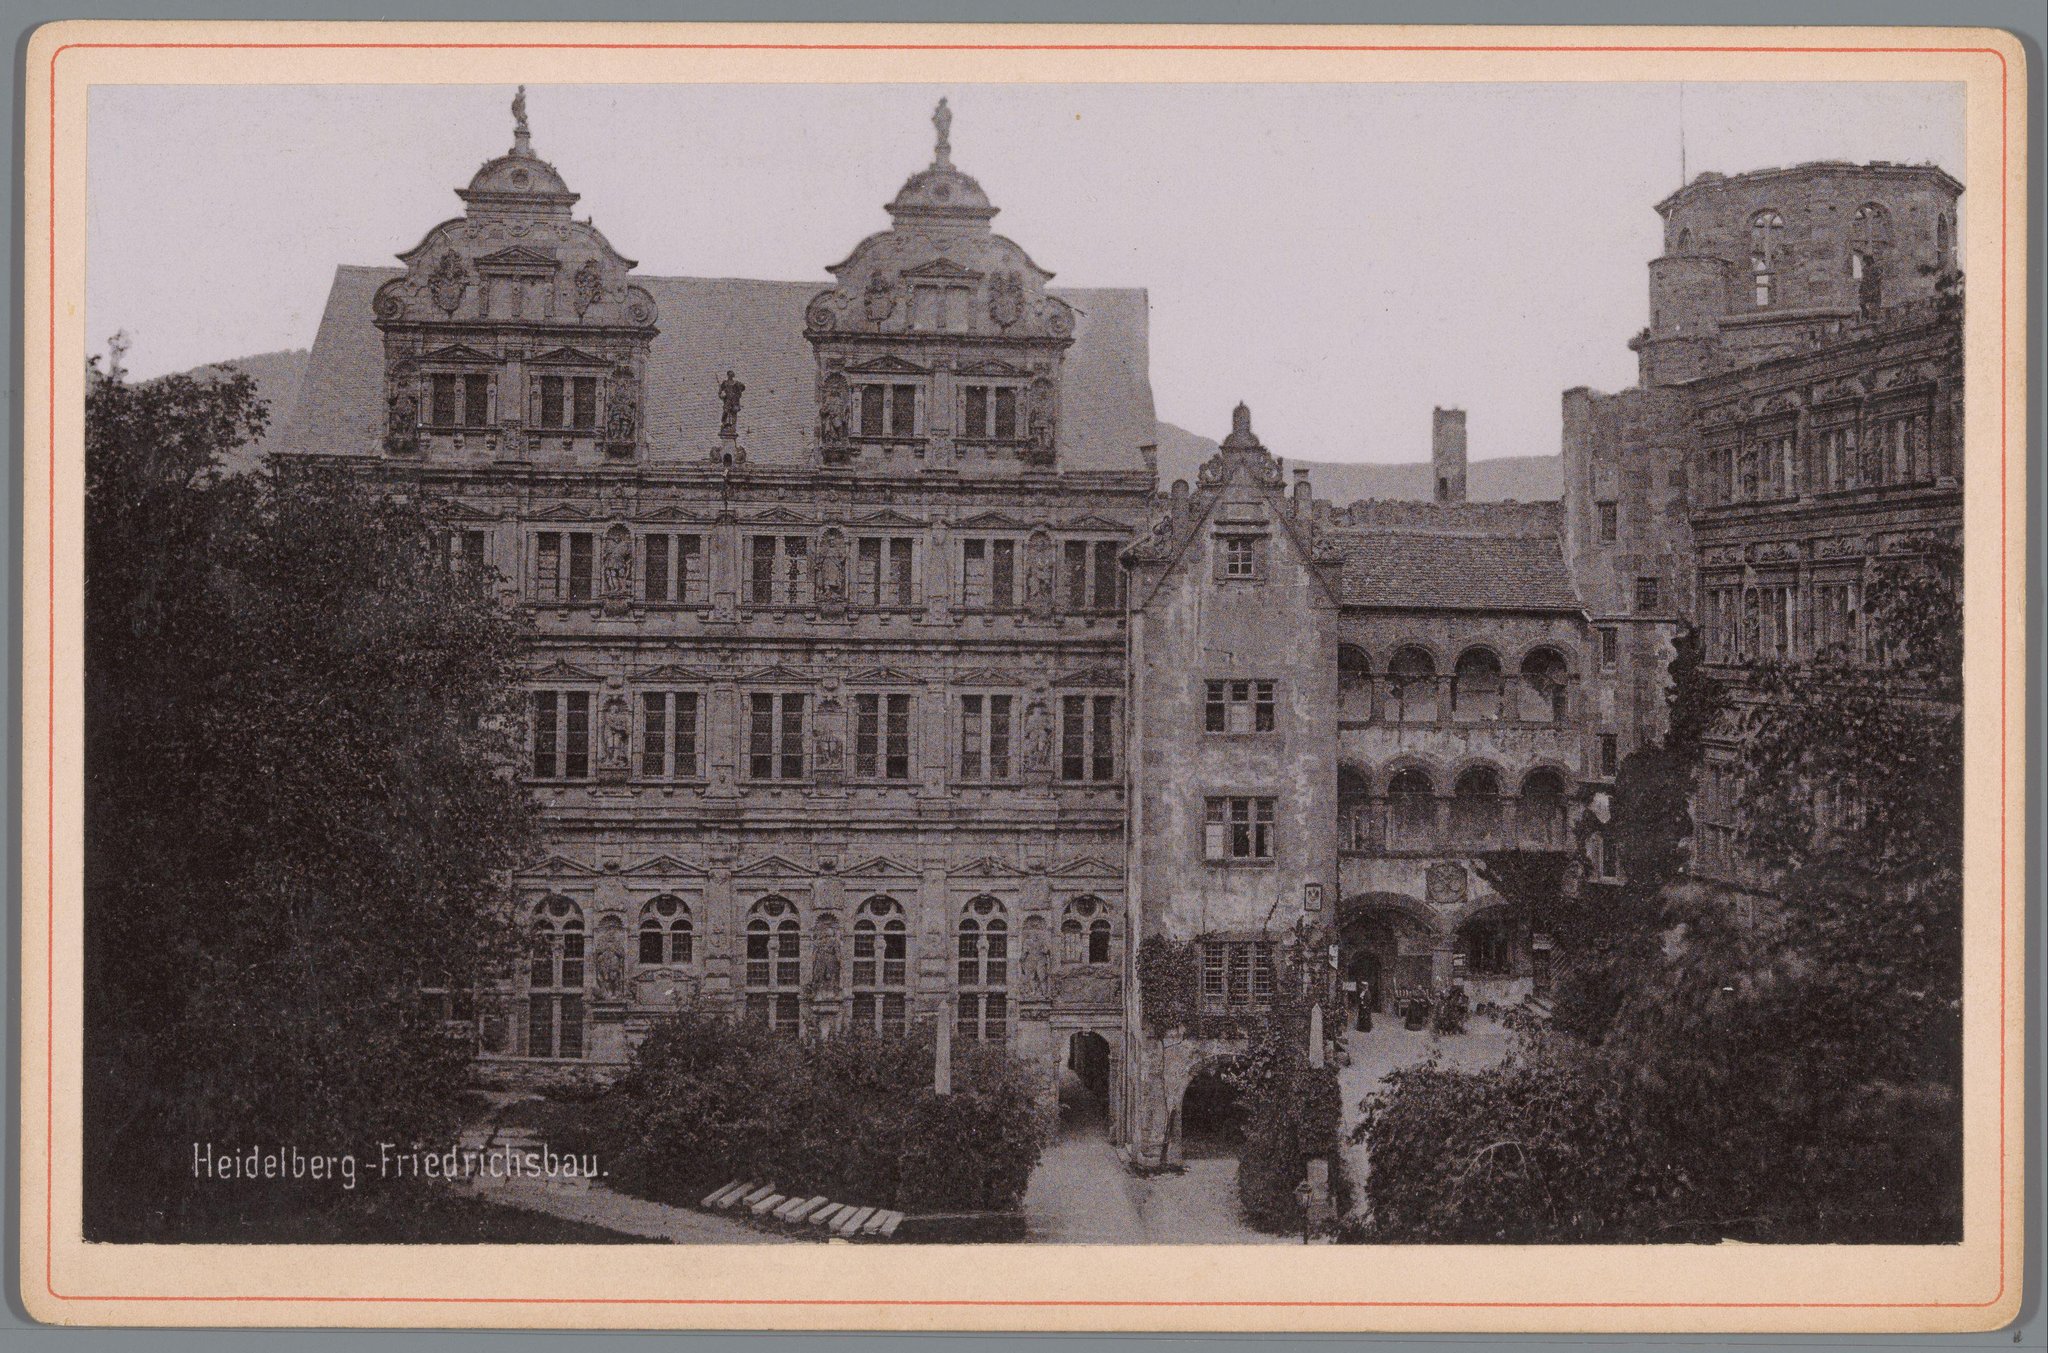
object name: cabinet photograph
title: Gezicht op het Friedrichsbau, onderdeel van het Schloss Heidelberg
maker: Anonymous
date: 1895-1900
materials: cardboard, paper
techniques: photograph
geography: heidelberg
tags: palace, façade (of house or building)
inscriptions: inscription: ‘Heidelberg (slot) 3 Aug. 1900.’